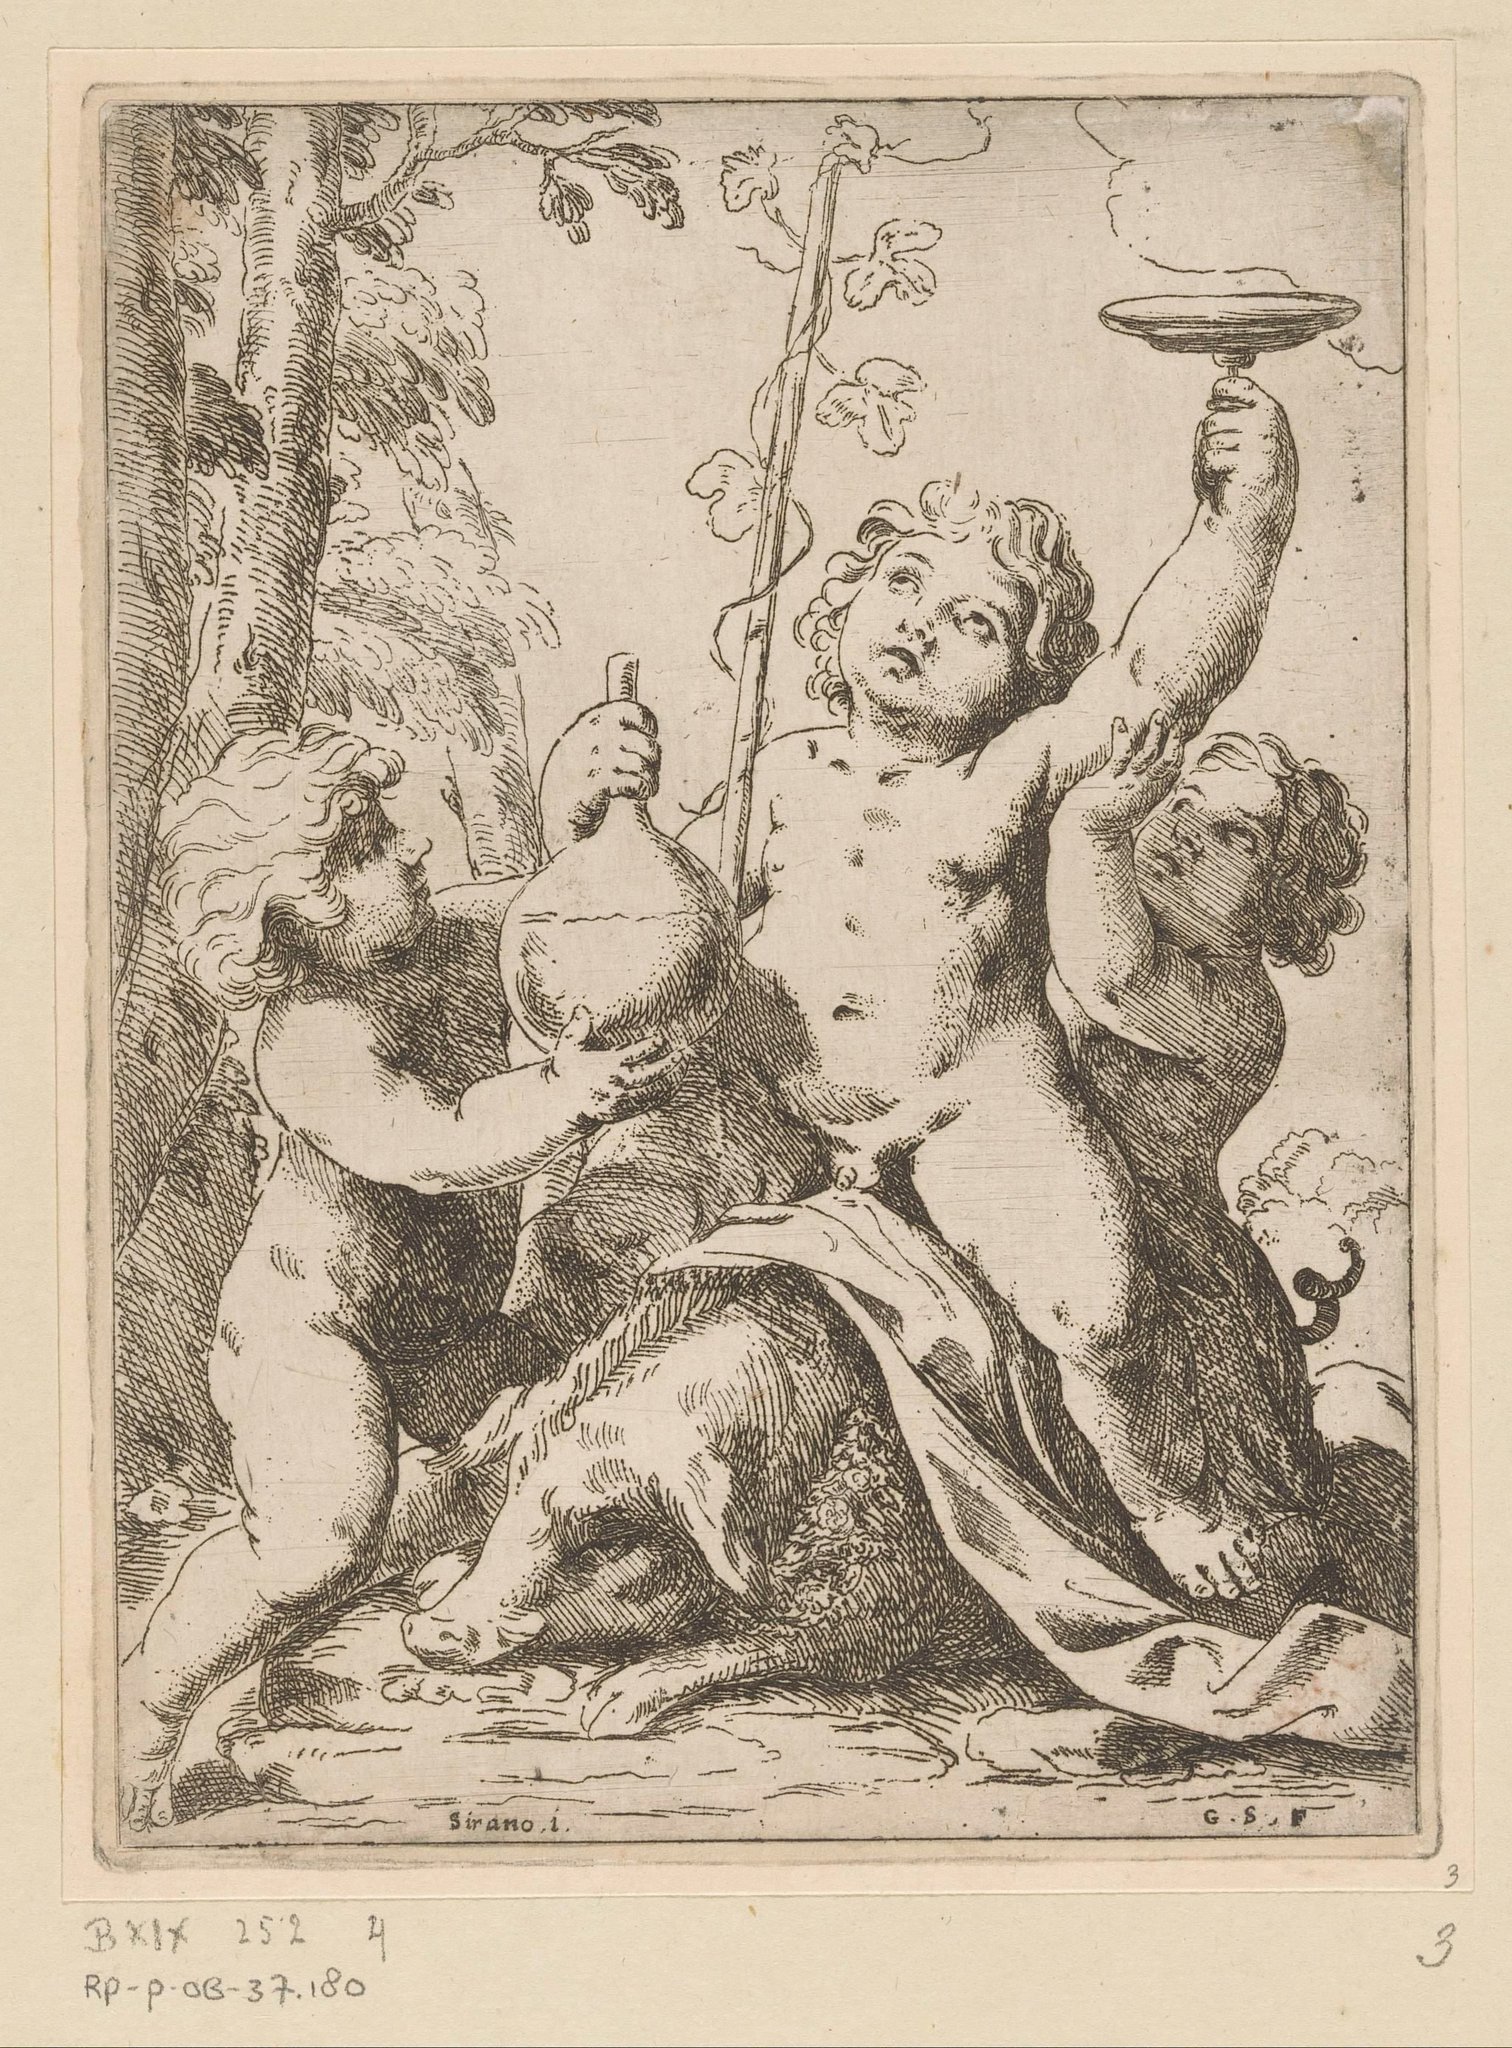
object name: print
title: Bacchanaal met drie jongelingen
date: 1620-1670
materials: paper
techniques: etching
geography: italy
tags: pig, children's bacchanal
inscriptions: collector's mark: Lugt 240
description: Een bacchanaal met in het midden een jongeling zittend op een varken met een drinkschaal in de hand. Links een jongeling met een fles.